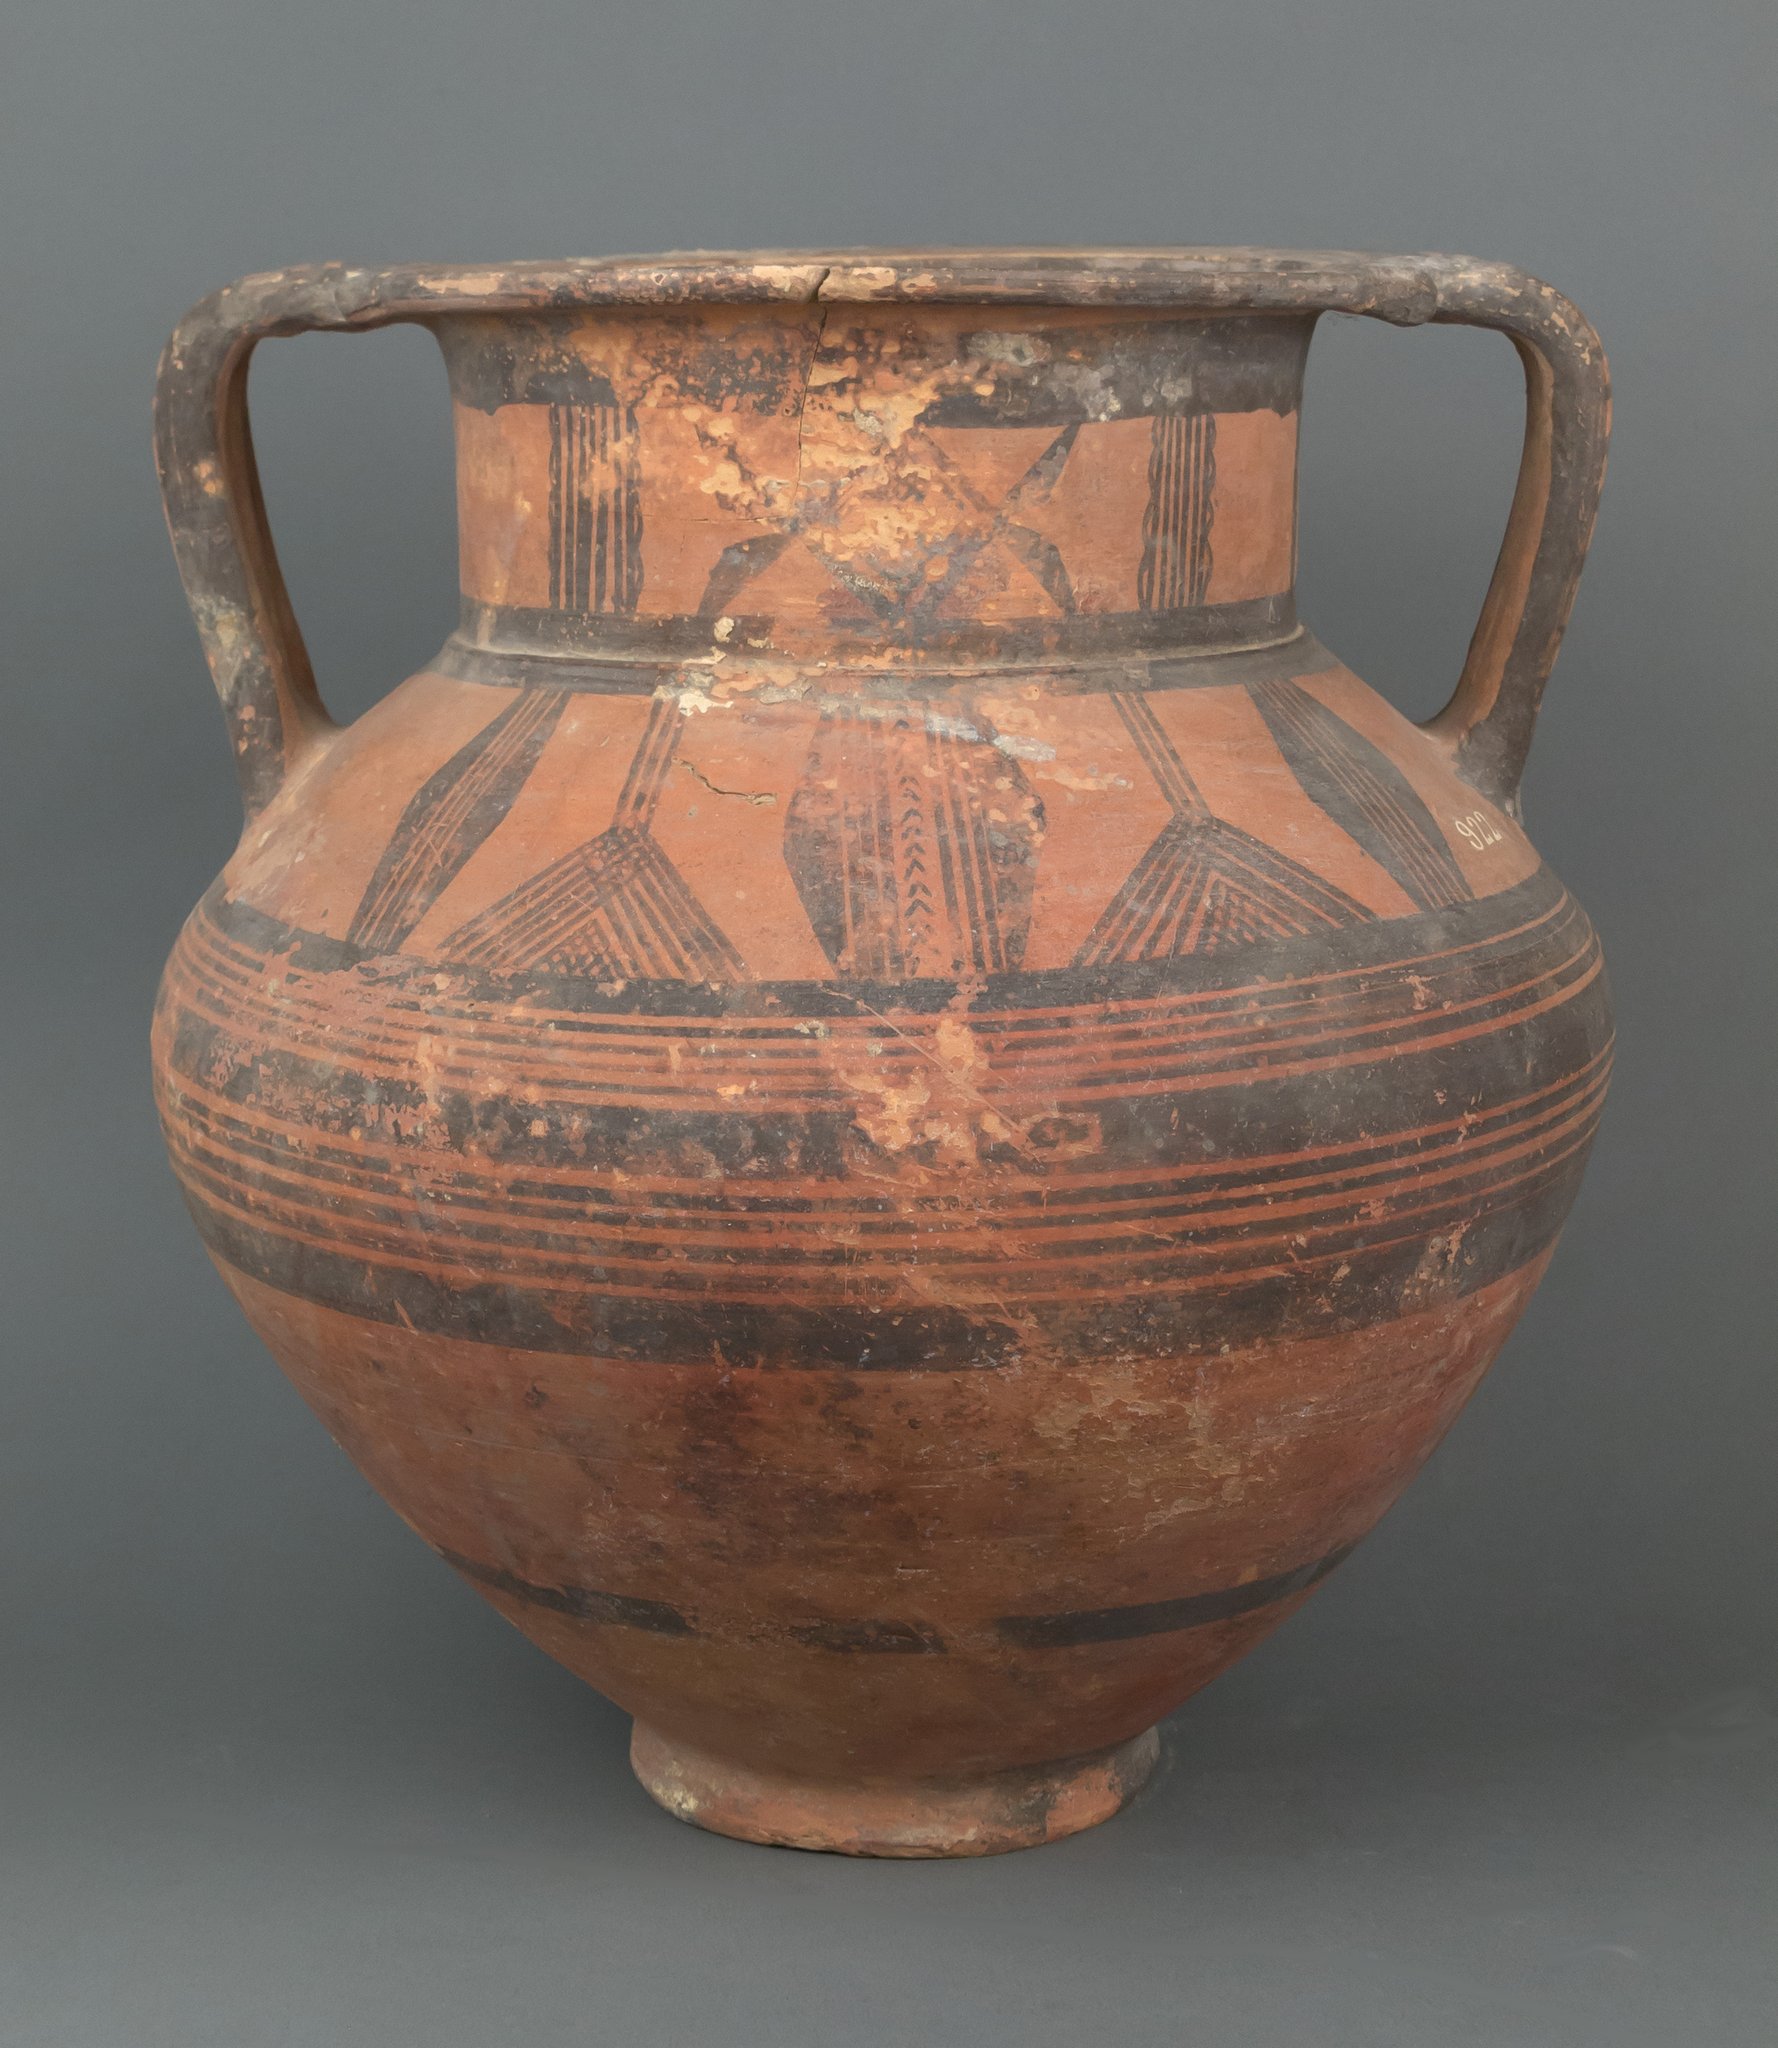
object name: amphora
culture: cypriot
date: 507-323 BCE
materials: terracotta